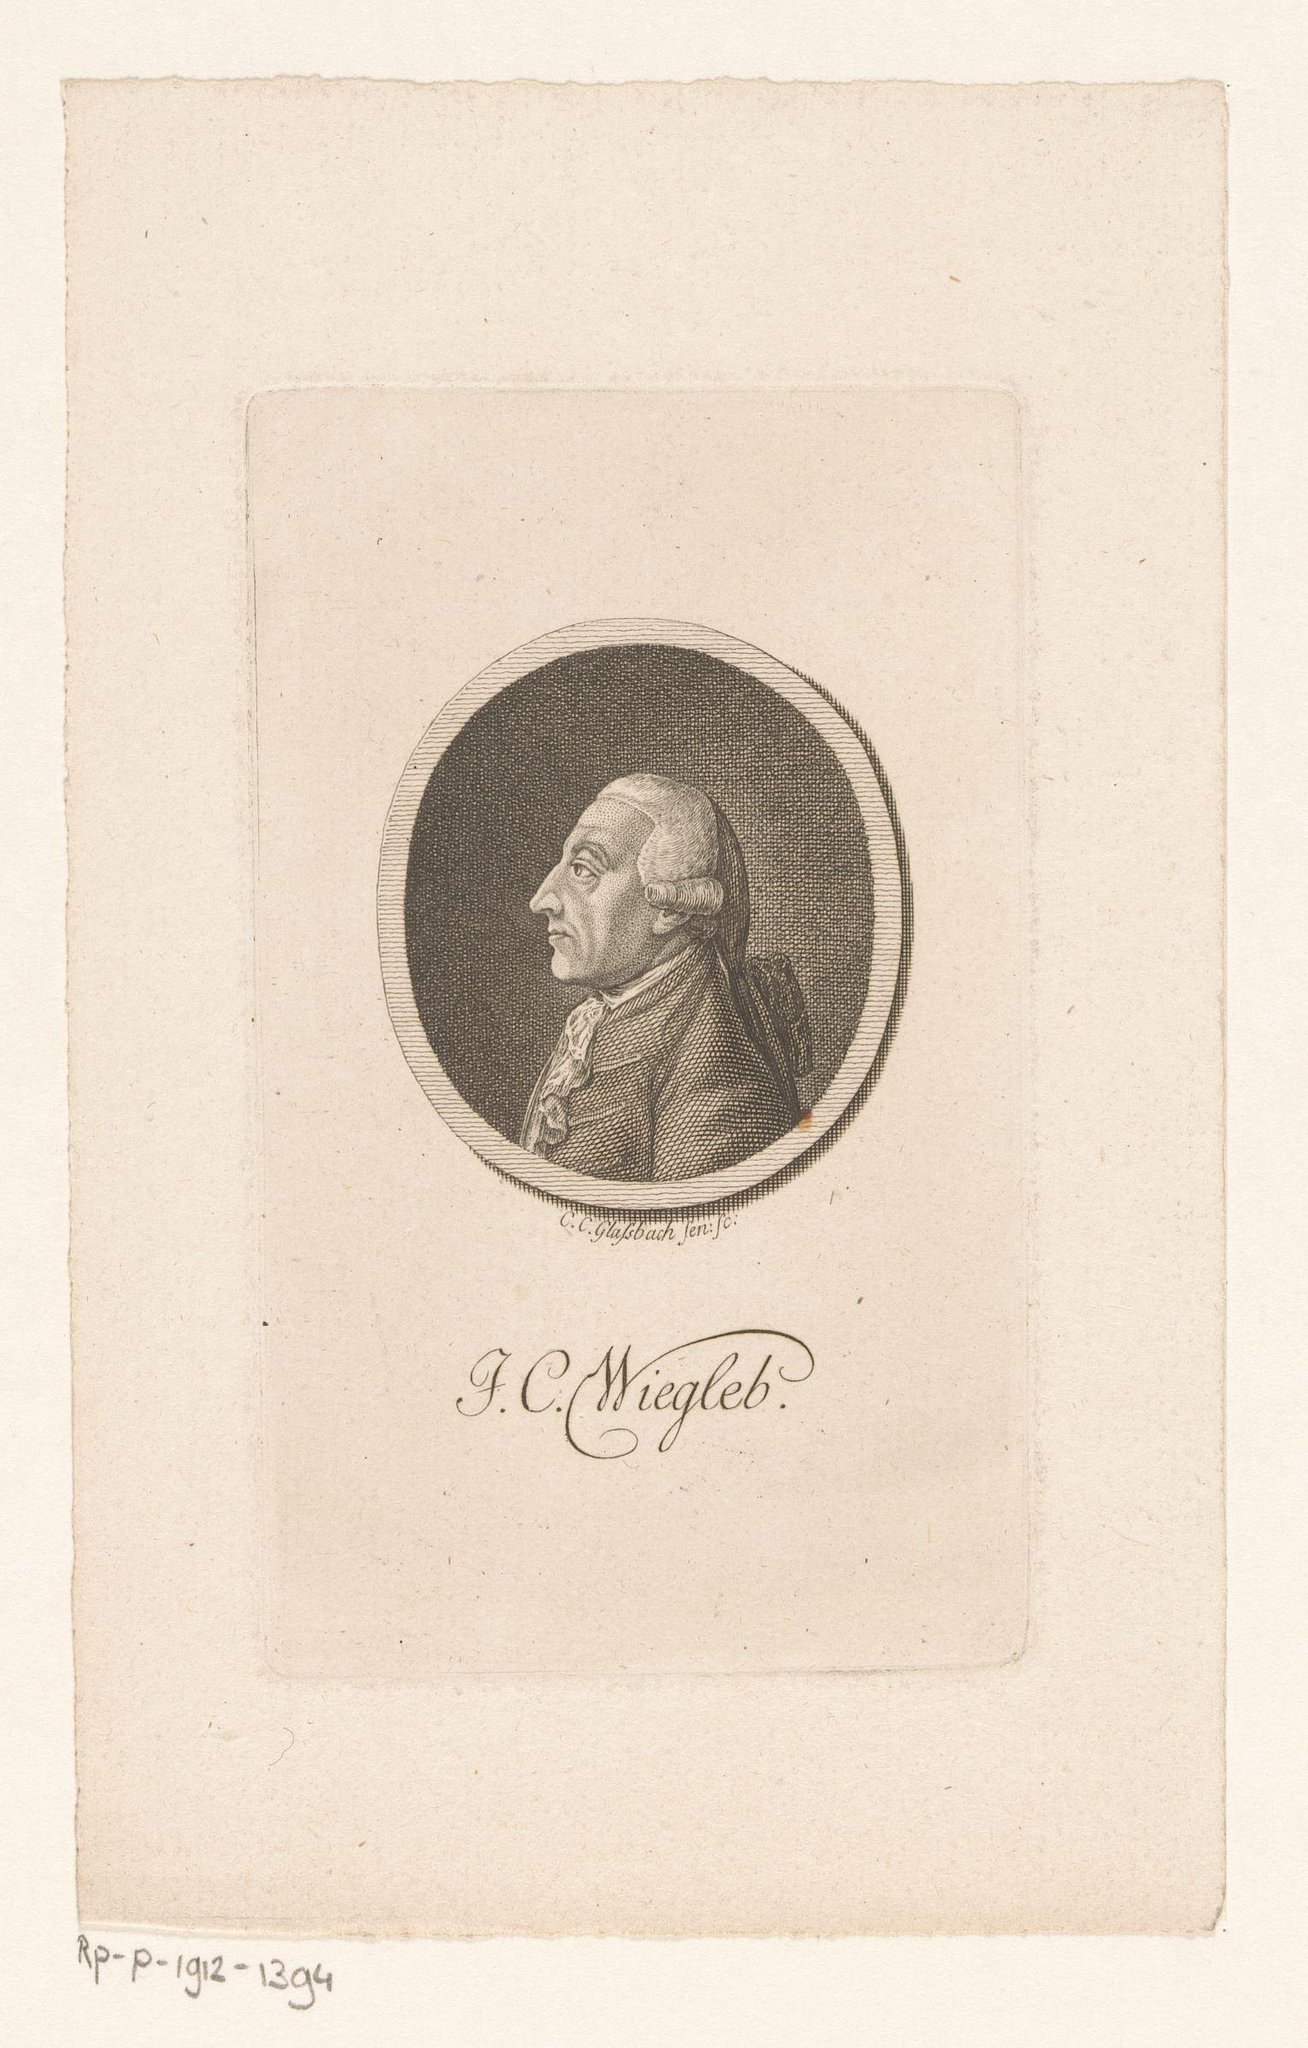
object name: print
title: Portret van Johann Christian Wiegleb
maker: carl christian glassbach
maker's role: print maker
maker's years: 1751-1789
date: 1761-1789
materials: paper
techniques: engraving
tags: pharmacist, druggist, apothecary; pharmacy, drugstore, dispensing chemist, historical persons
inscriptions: collector's mark: Lugt 2228